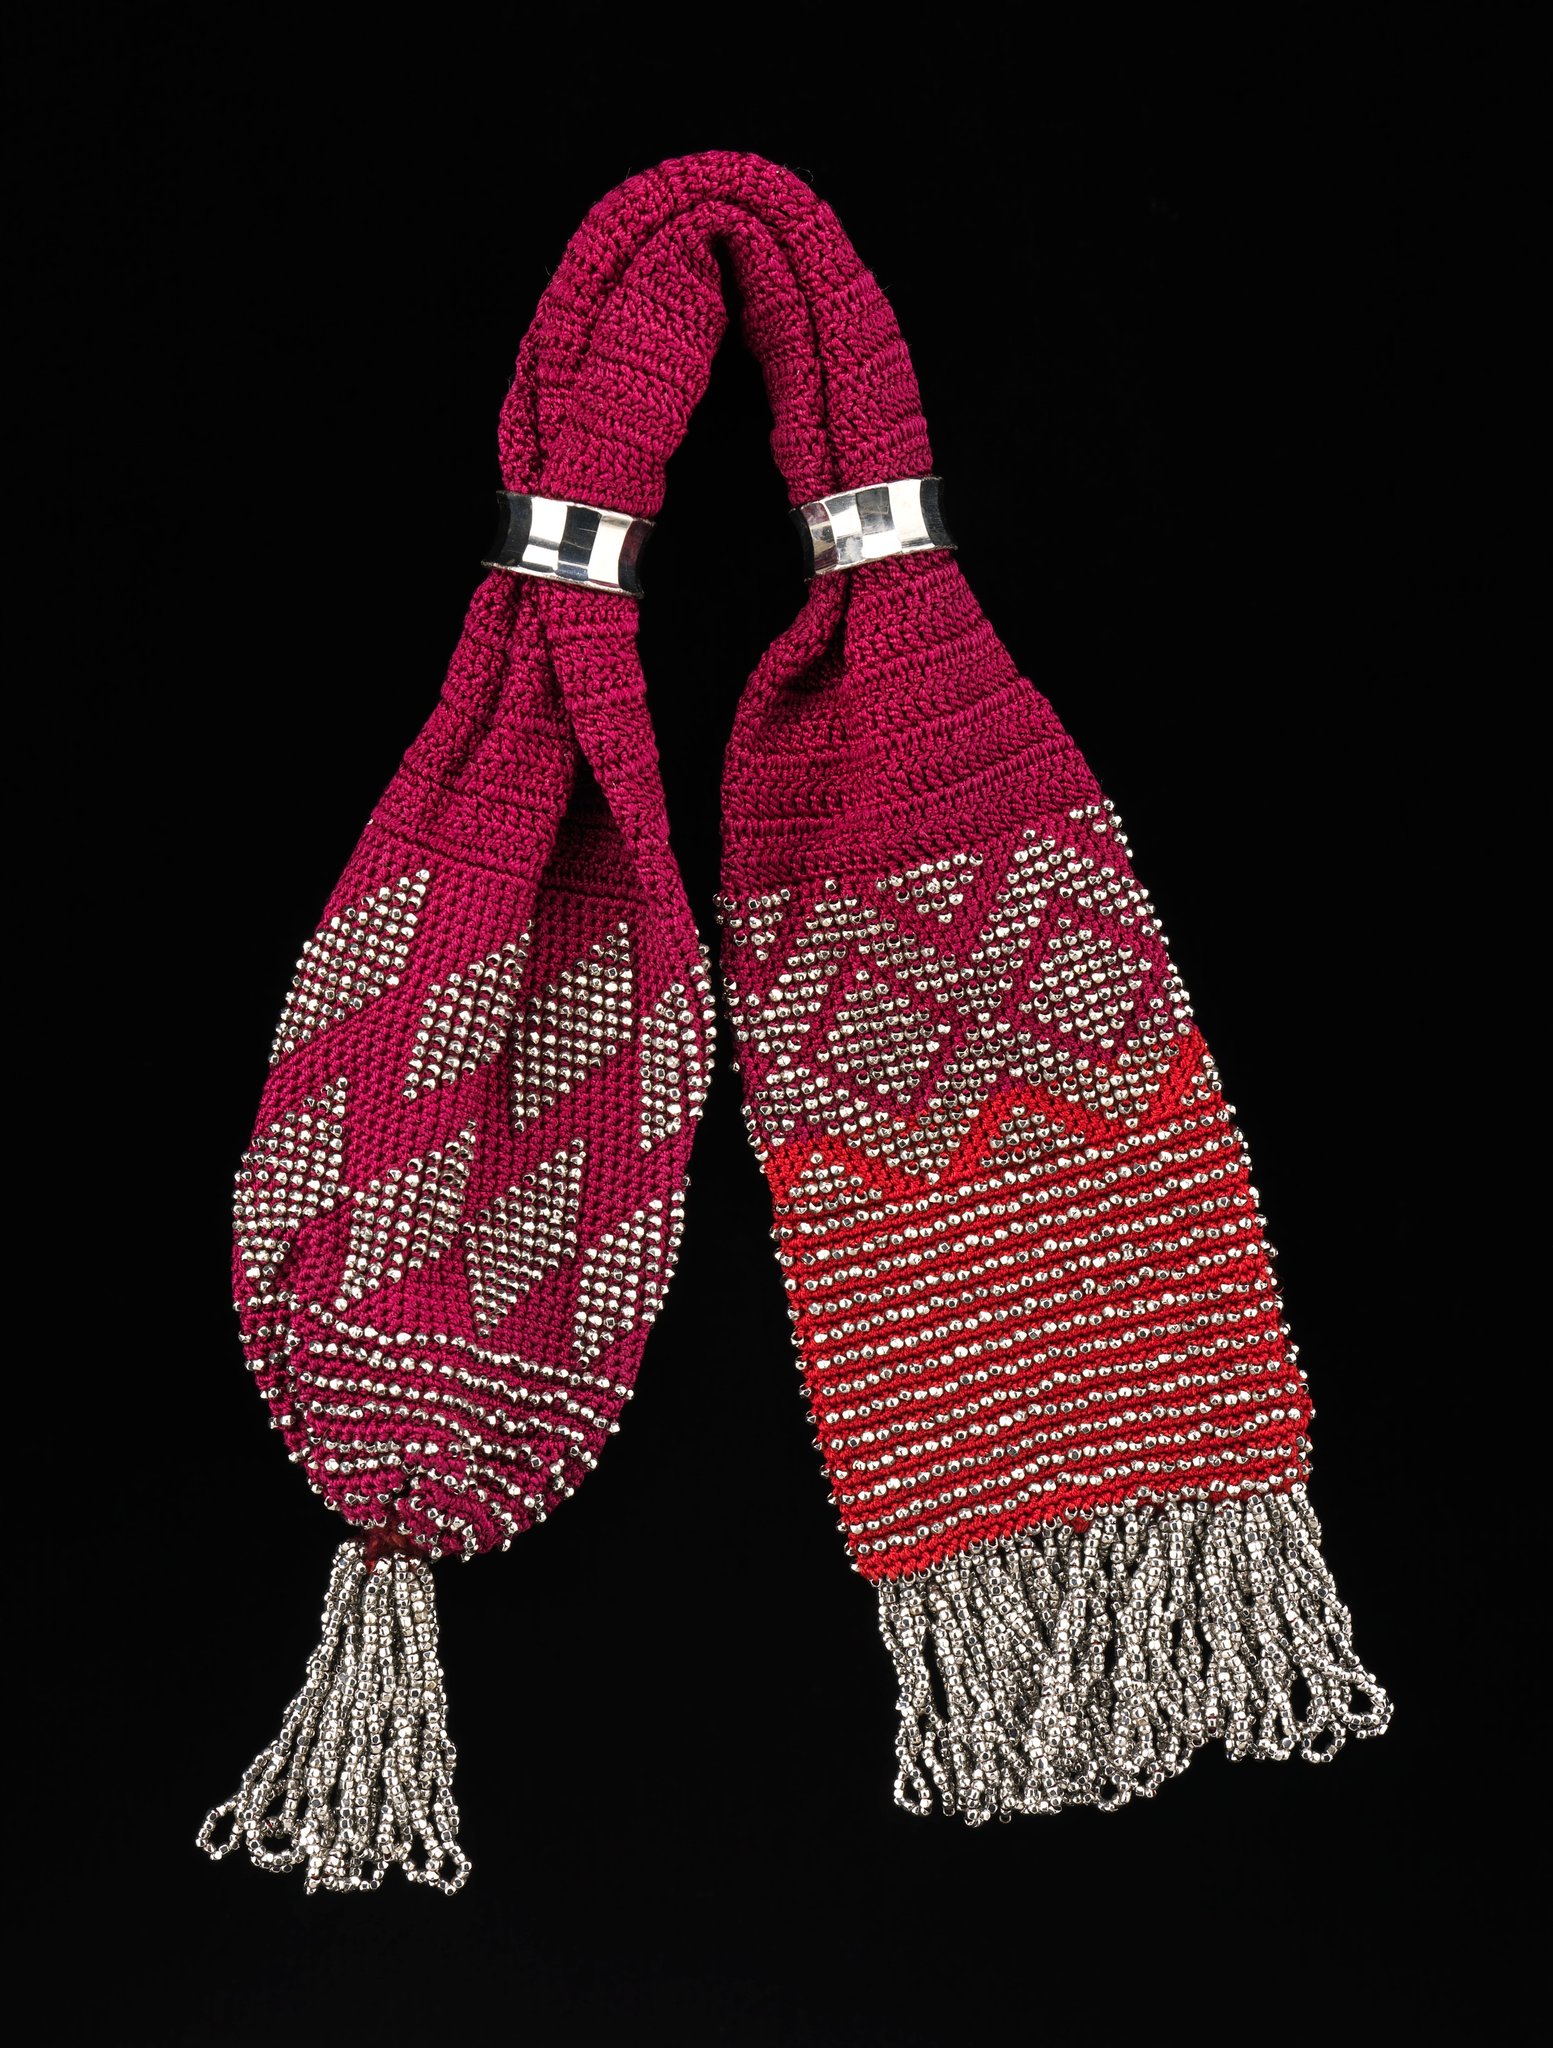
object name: miser's purse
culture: american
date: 1840-1860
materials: cotton, metal